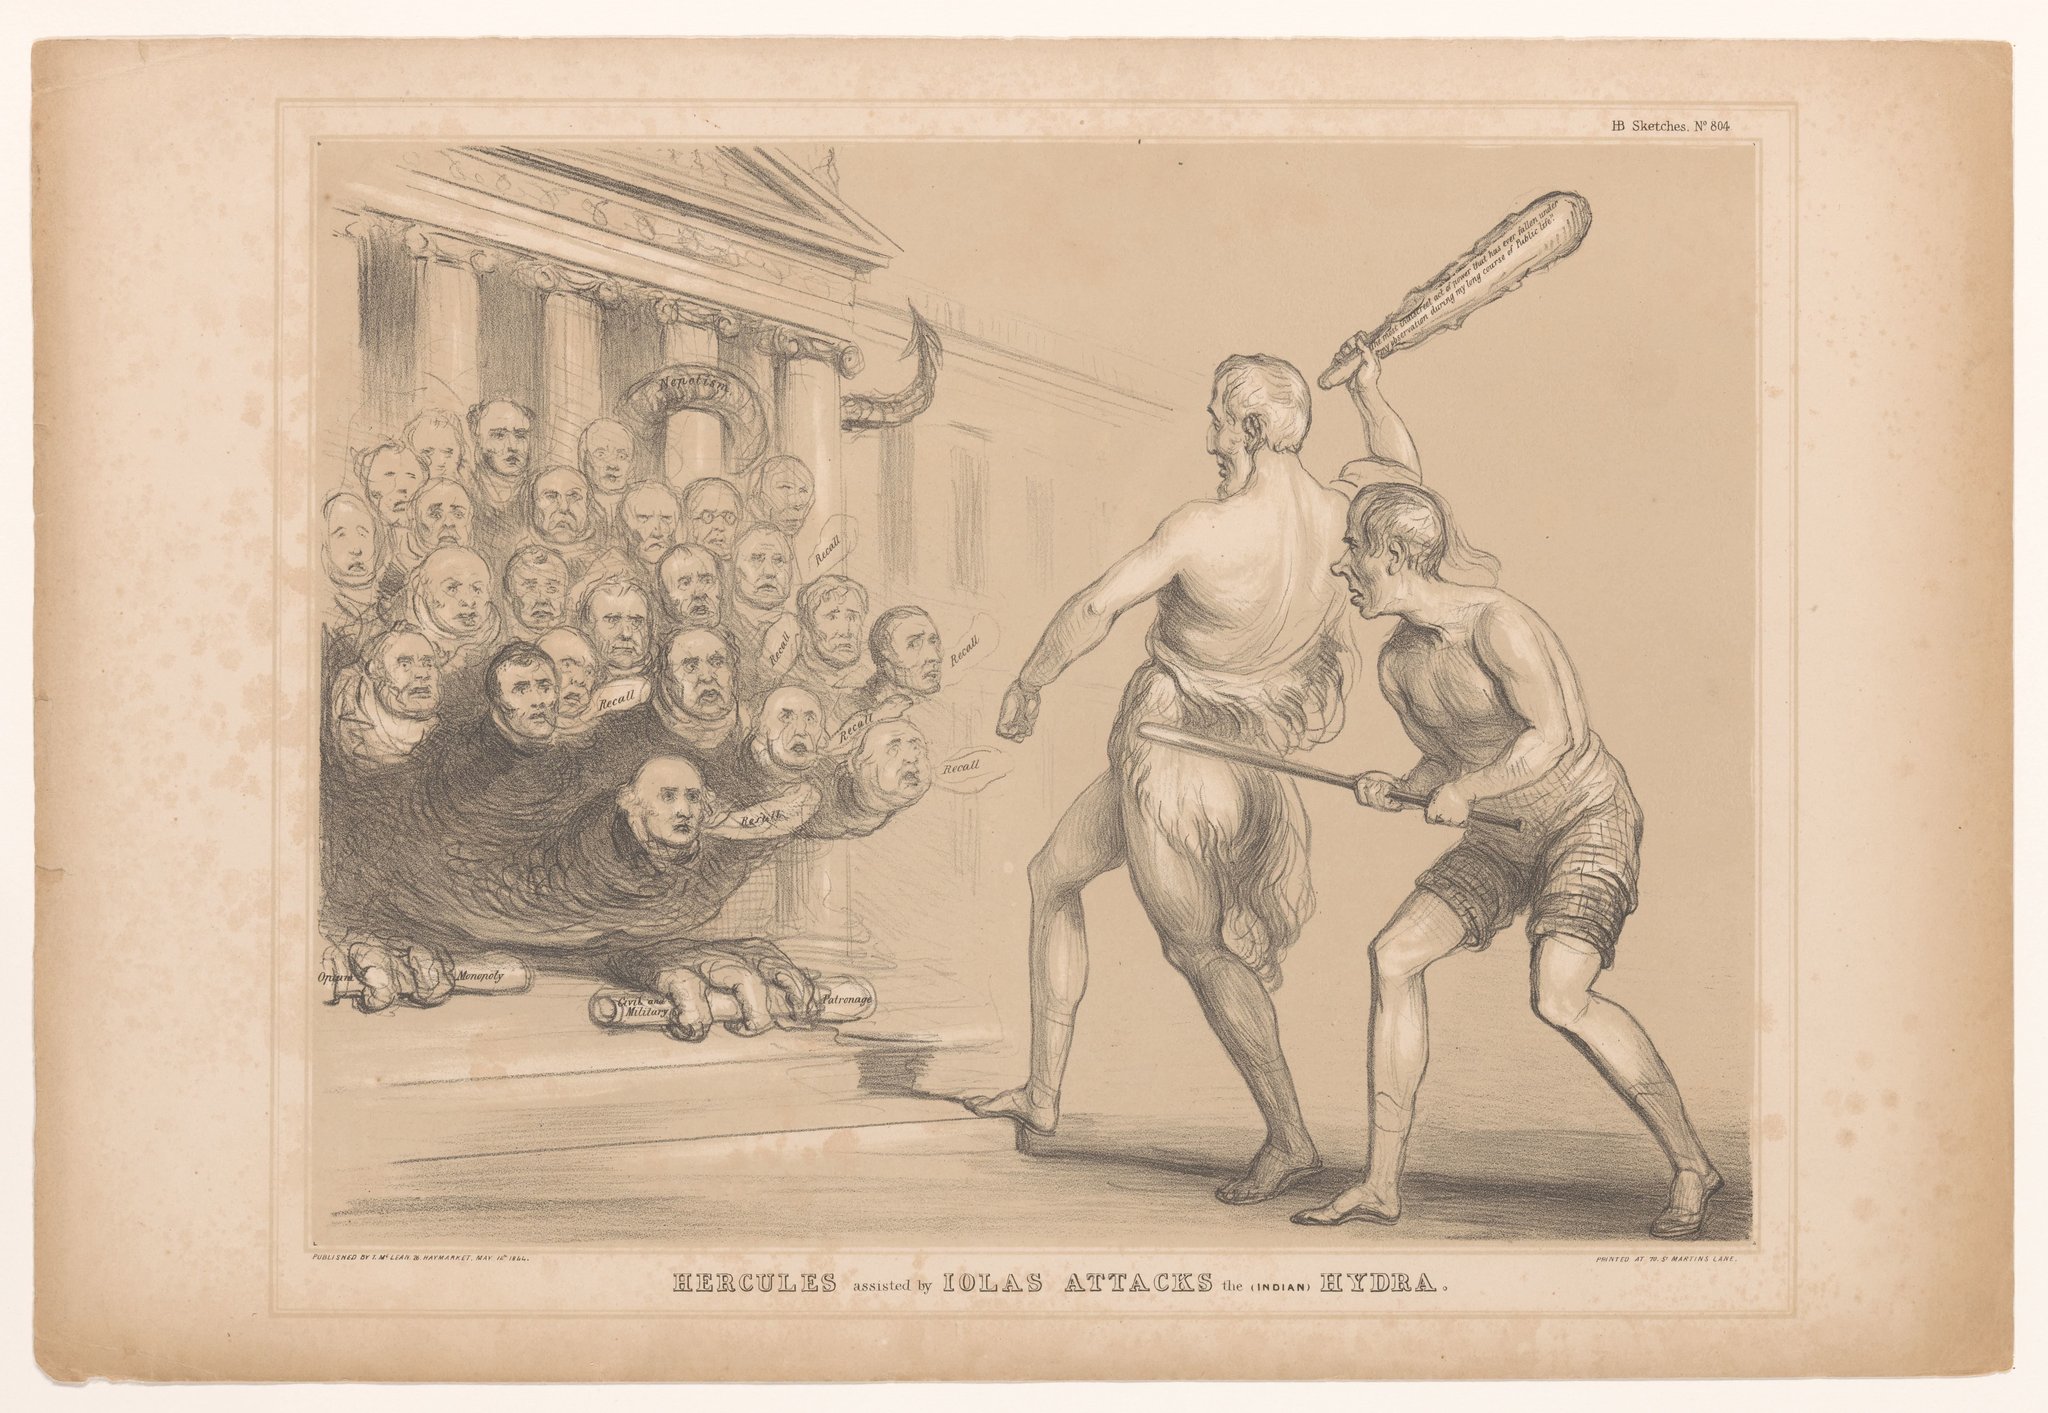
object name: cartoon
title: Hercules, assisted by Iolas attacks the (Indian) Hydra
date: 1844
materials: paper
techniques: tone lithography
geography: london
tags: walmer castle, arthur wellesley of wellington, (2) the hydra of lerna is killed by hercules, political caricatures and satires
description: Spotprent over Engelse binnenlandse politiek in 1844 met de hertog van Wellington die als Hercules samen met Lord Brougham de hydra (British East India Company ) aanvalt. Uitgegeven als nr. 804 in de serie HB Sketches.